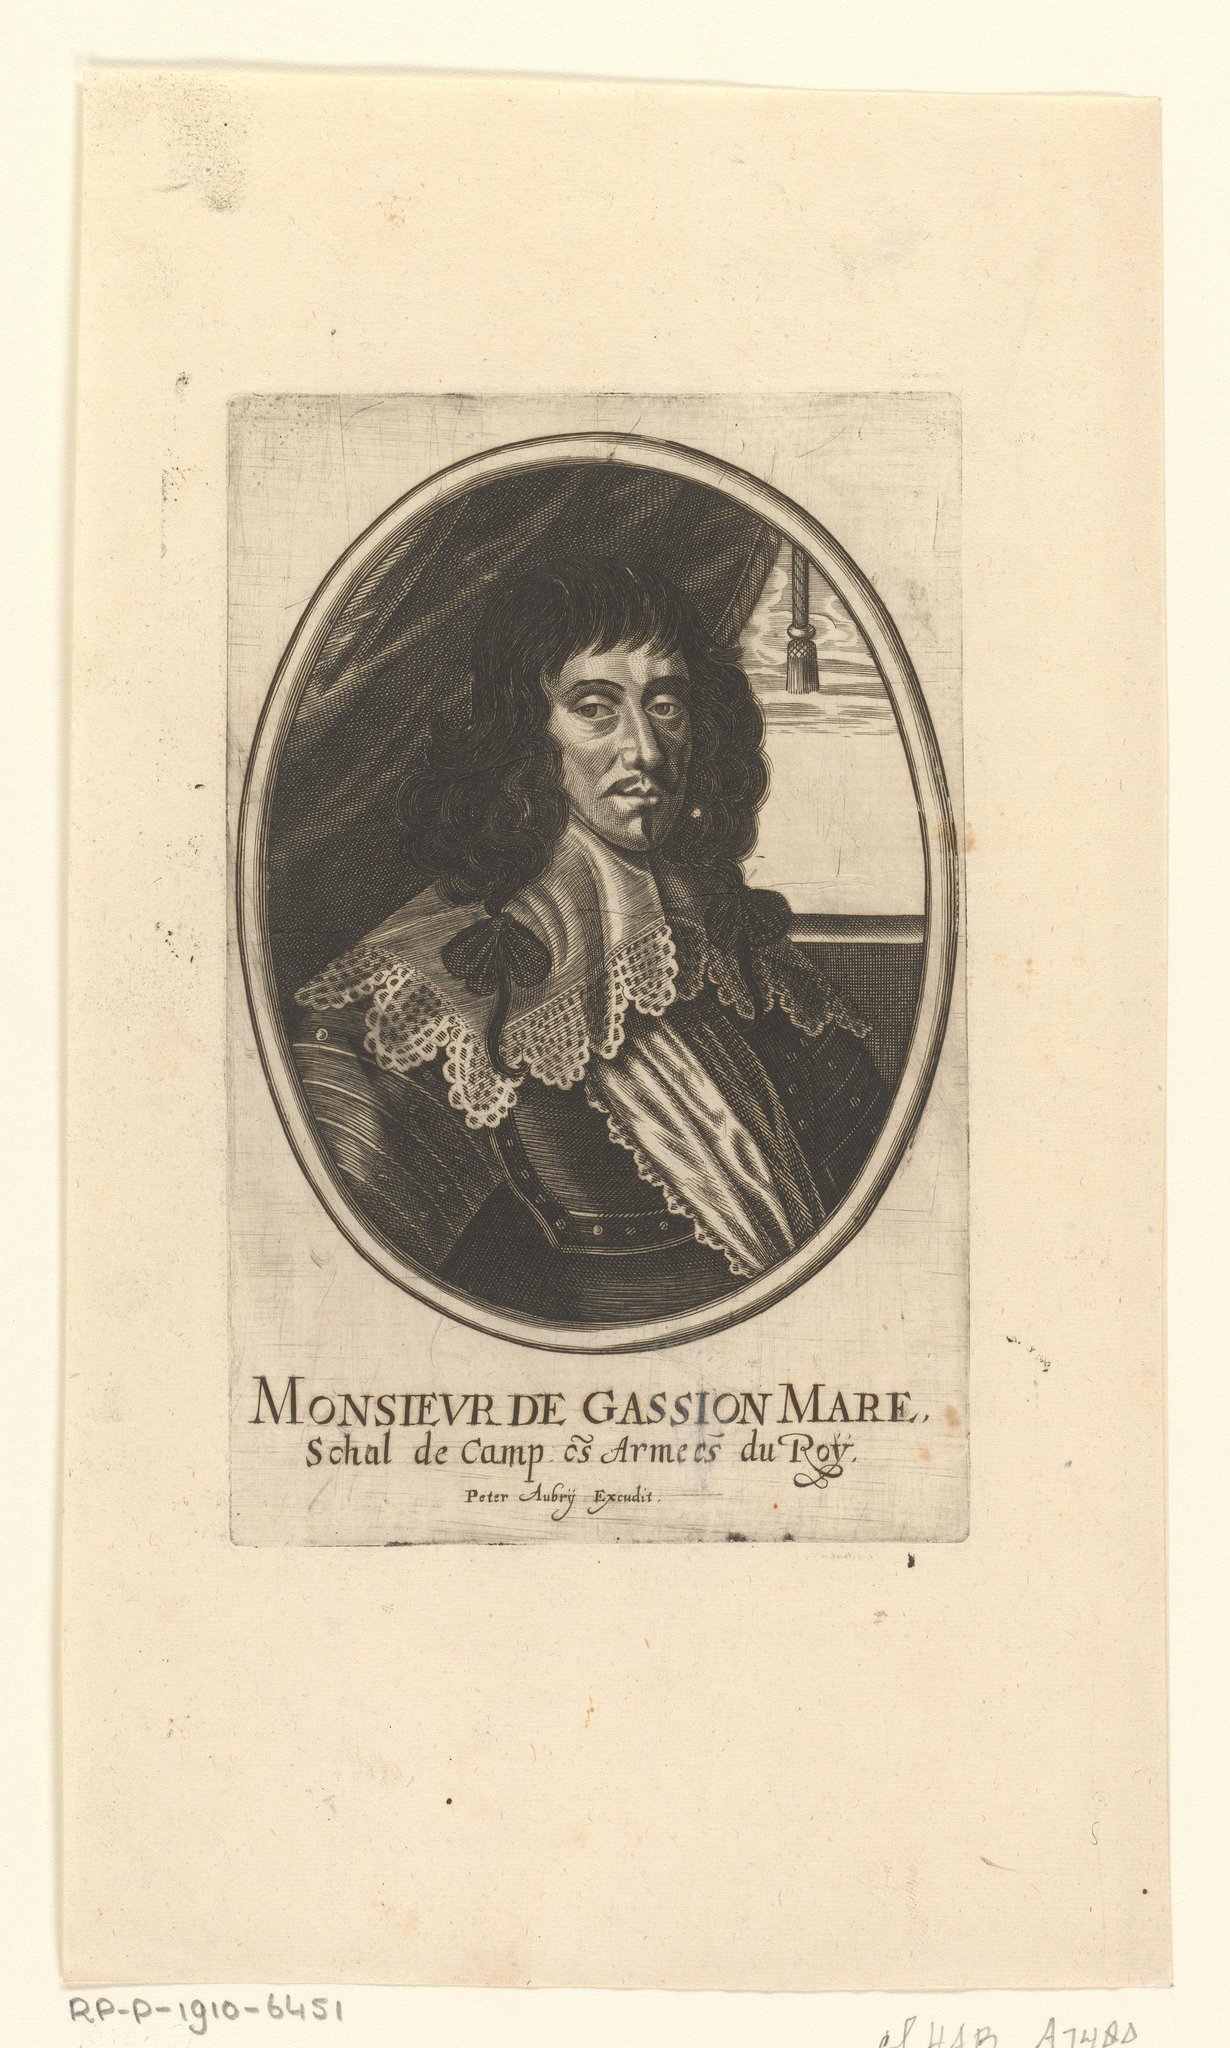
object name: print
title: Portret van Jean de Gassion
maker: Anonymous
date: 1643-1686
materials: paper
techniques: engraving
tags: commander-in-chief, general, marshal, historical persons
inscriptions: collector's mark: Lugt 2228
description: Met tweeregelig onderschrift in het Frans.